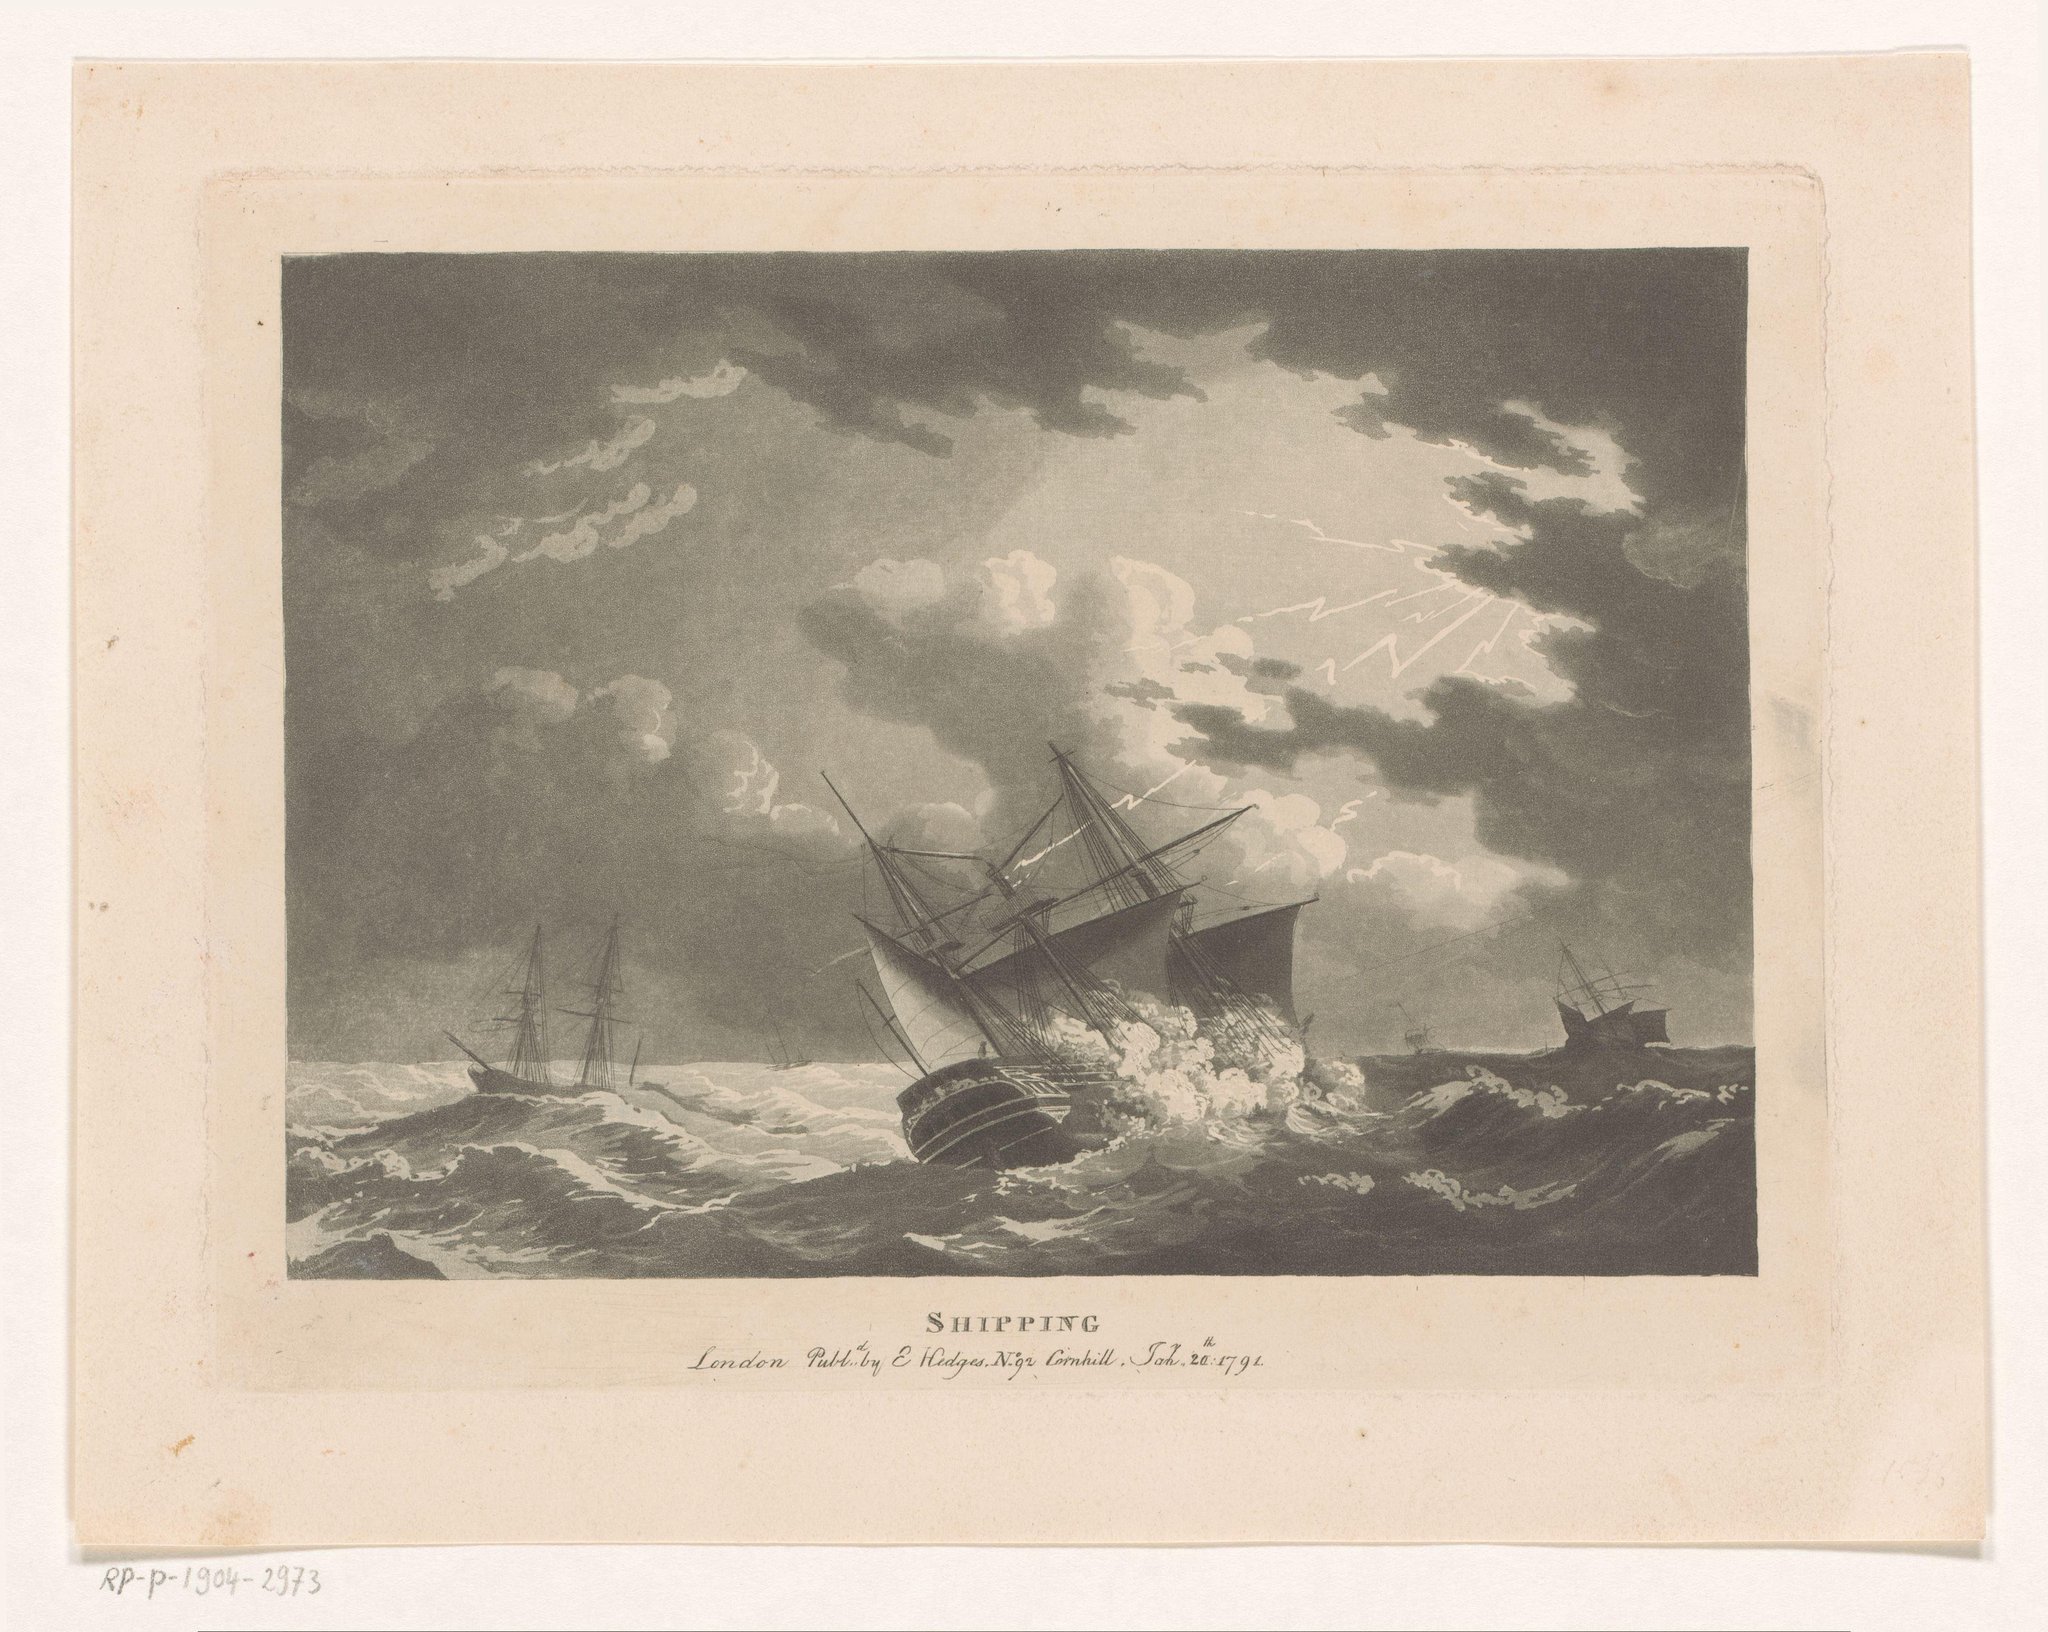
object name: print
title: Shipping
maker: edward hedges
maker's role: publisher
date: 1791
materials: paper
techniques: etching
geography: london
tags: ships (in general), thunderstorm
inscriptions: collector's mark: Lugt 2228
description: Deze prent maakt deel uit van een serie van vier prenten.